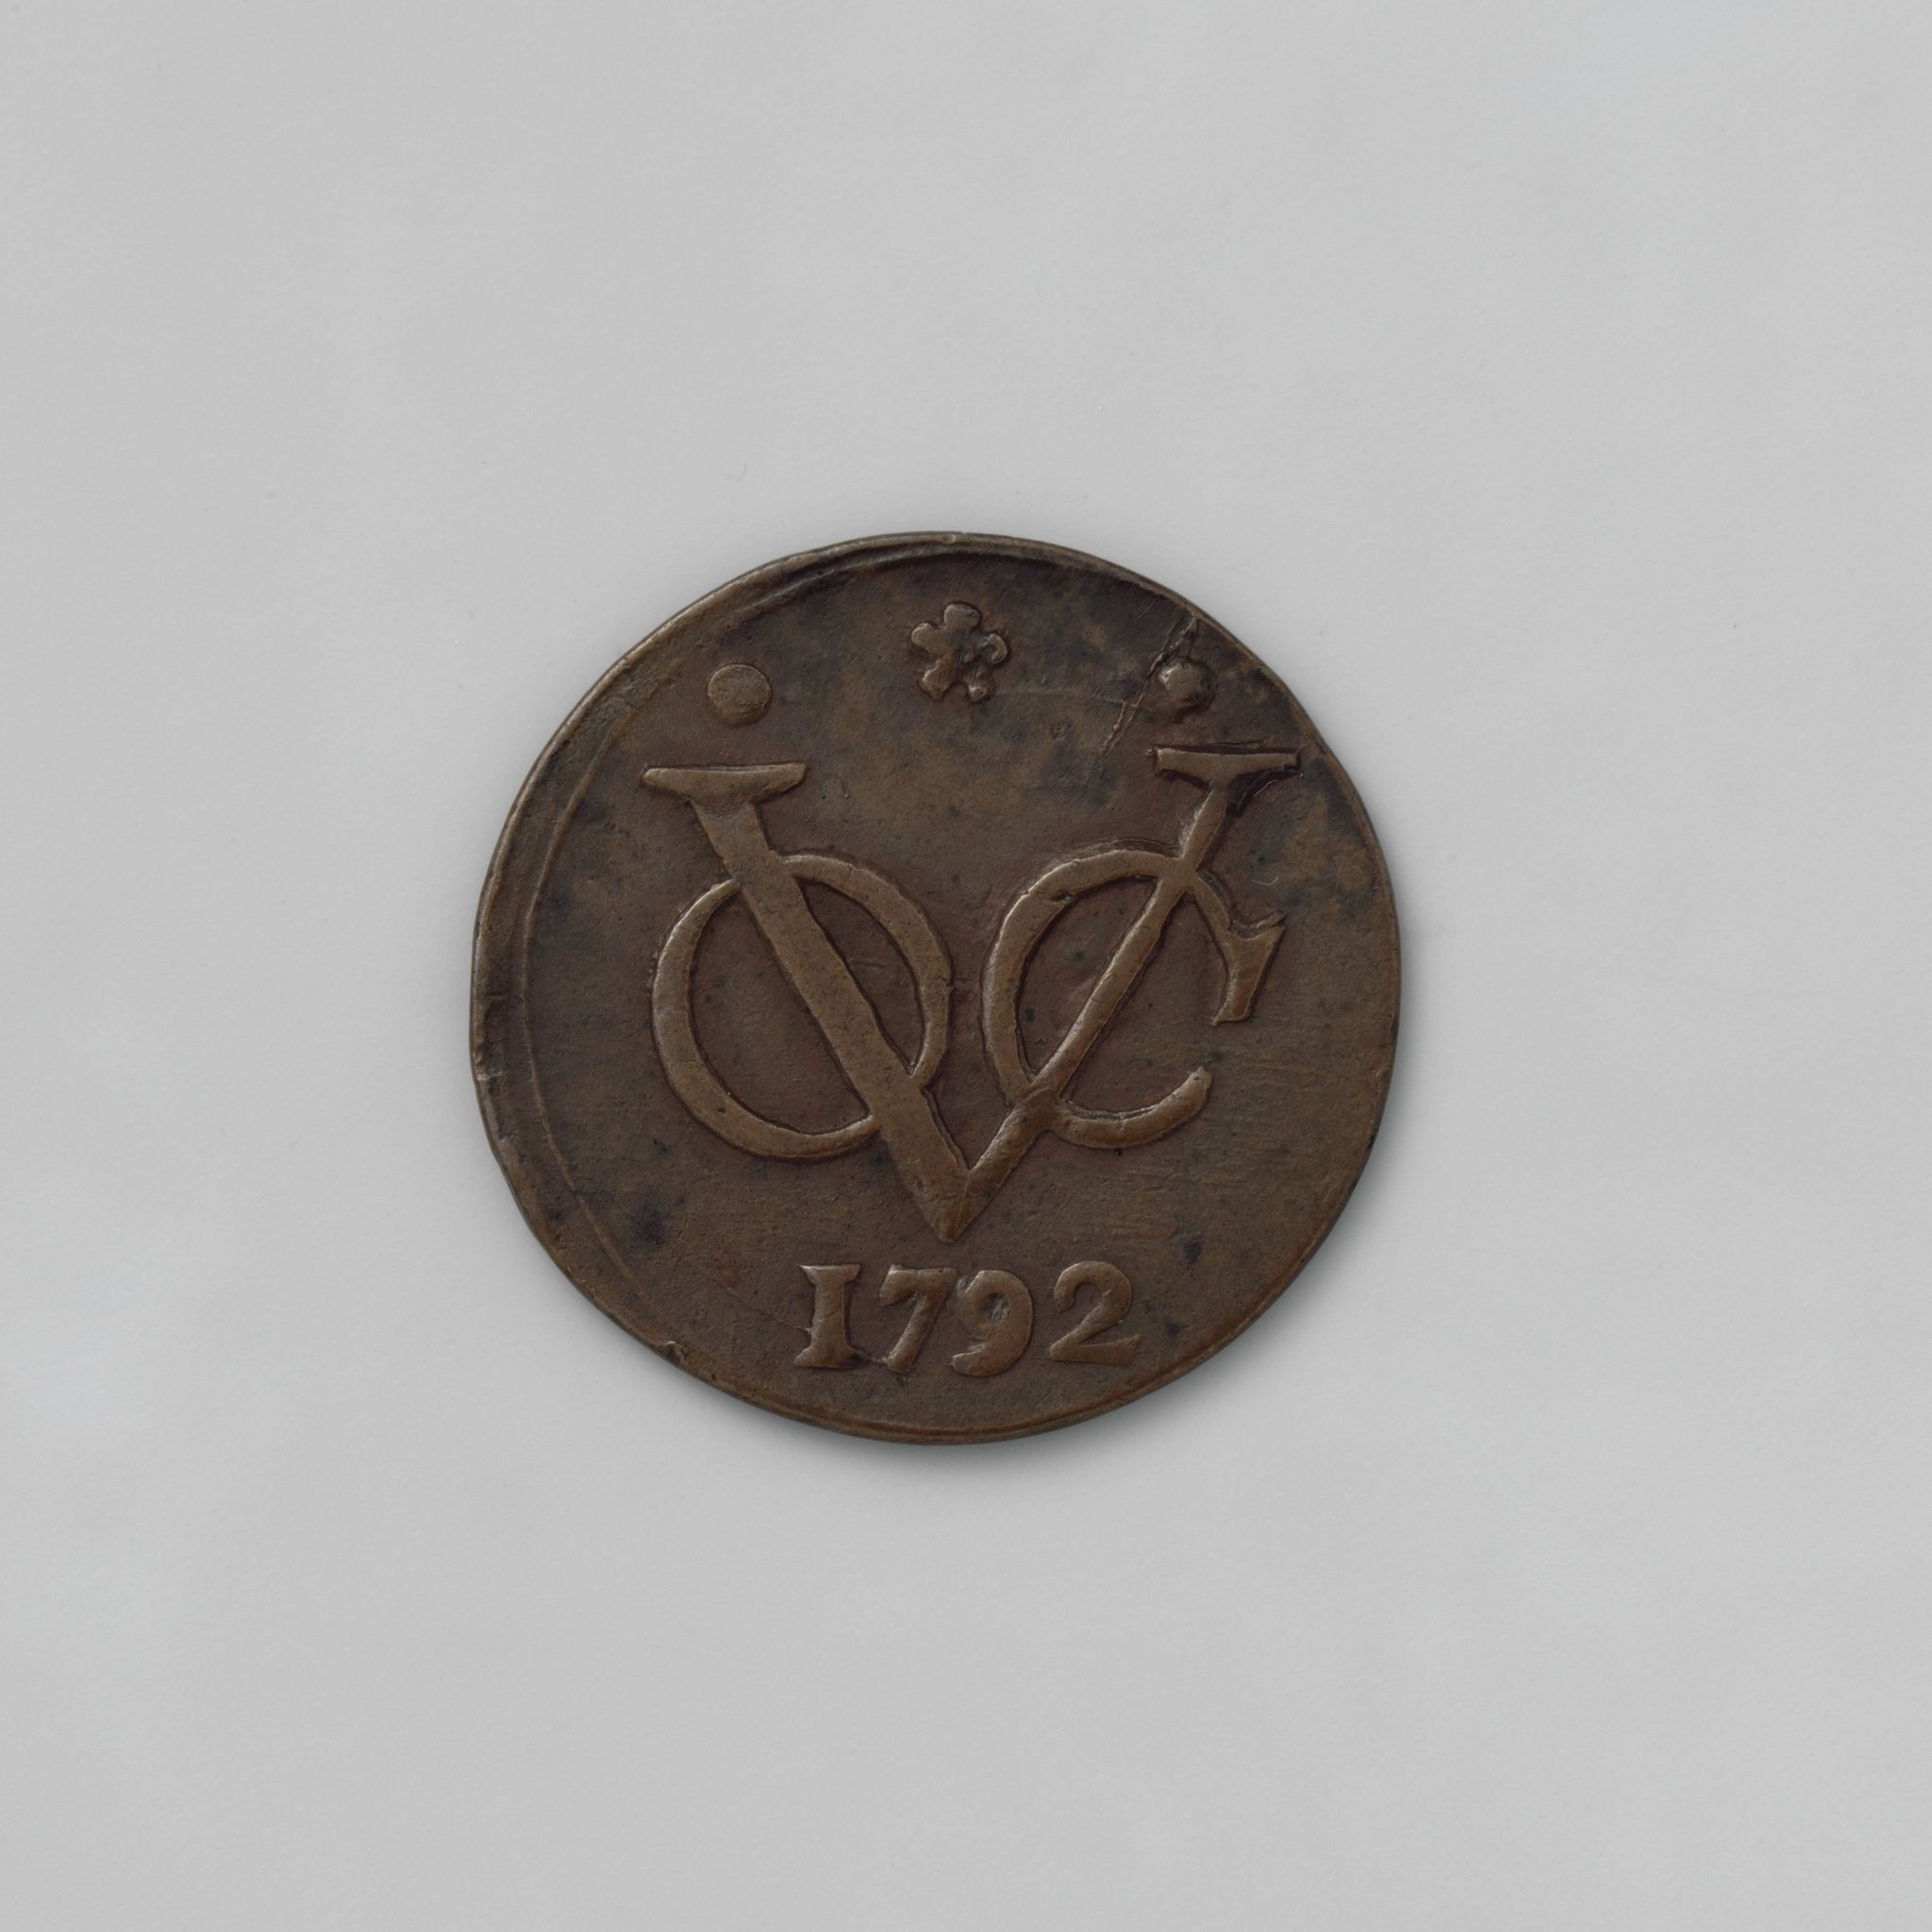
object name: coin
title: Duit van de VOC uit Westfriesland, 1792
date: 1792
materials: copper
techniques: striking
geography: enkhuizen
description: Koperen munt. Voorzijde: gekroond wapenschild van Westfriesland. Keerzijde: monogram van de VOC, waarboven muntteken en waaronder jaartal. Gladde rand.